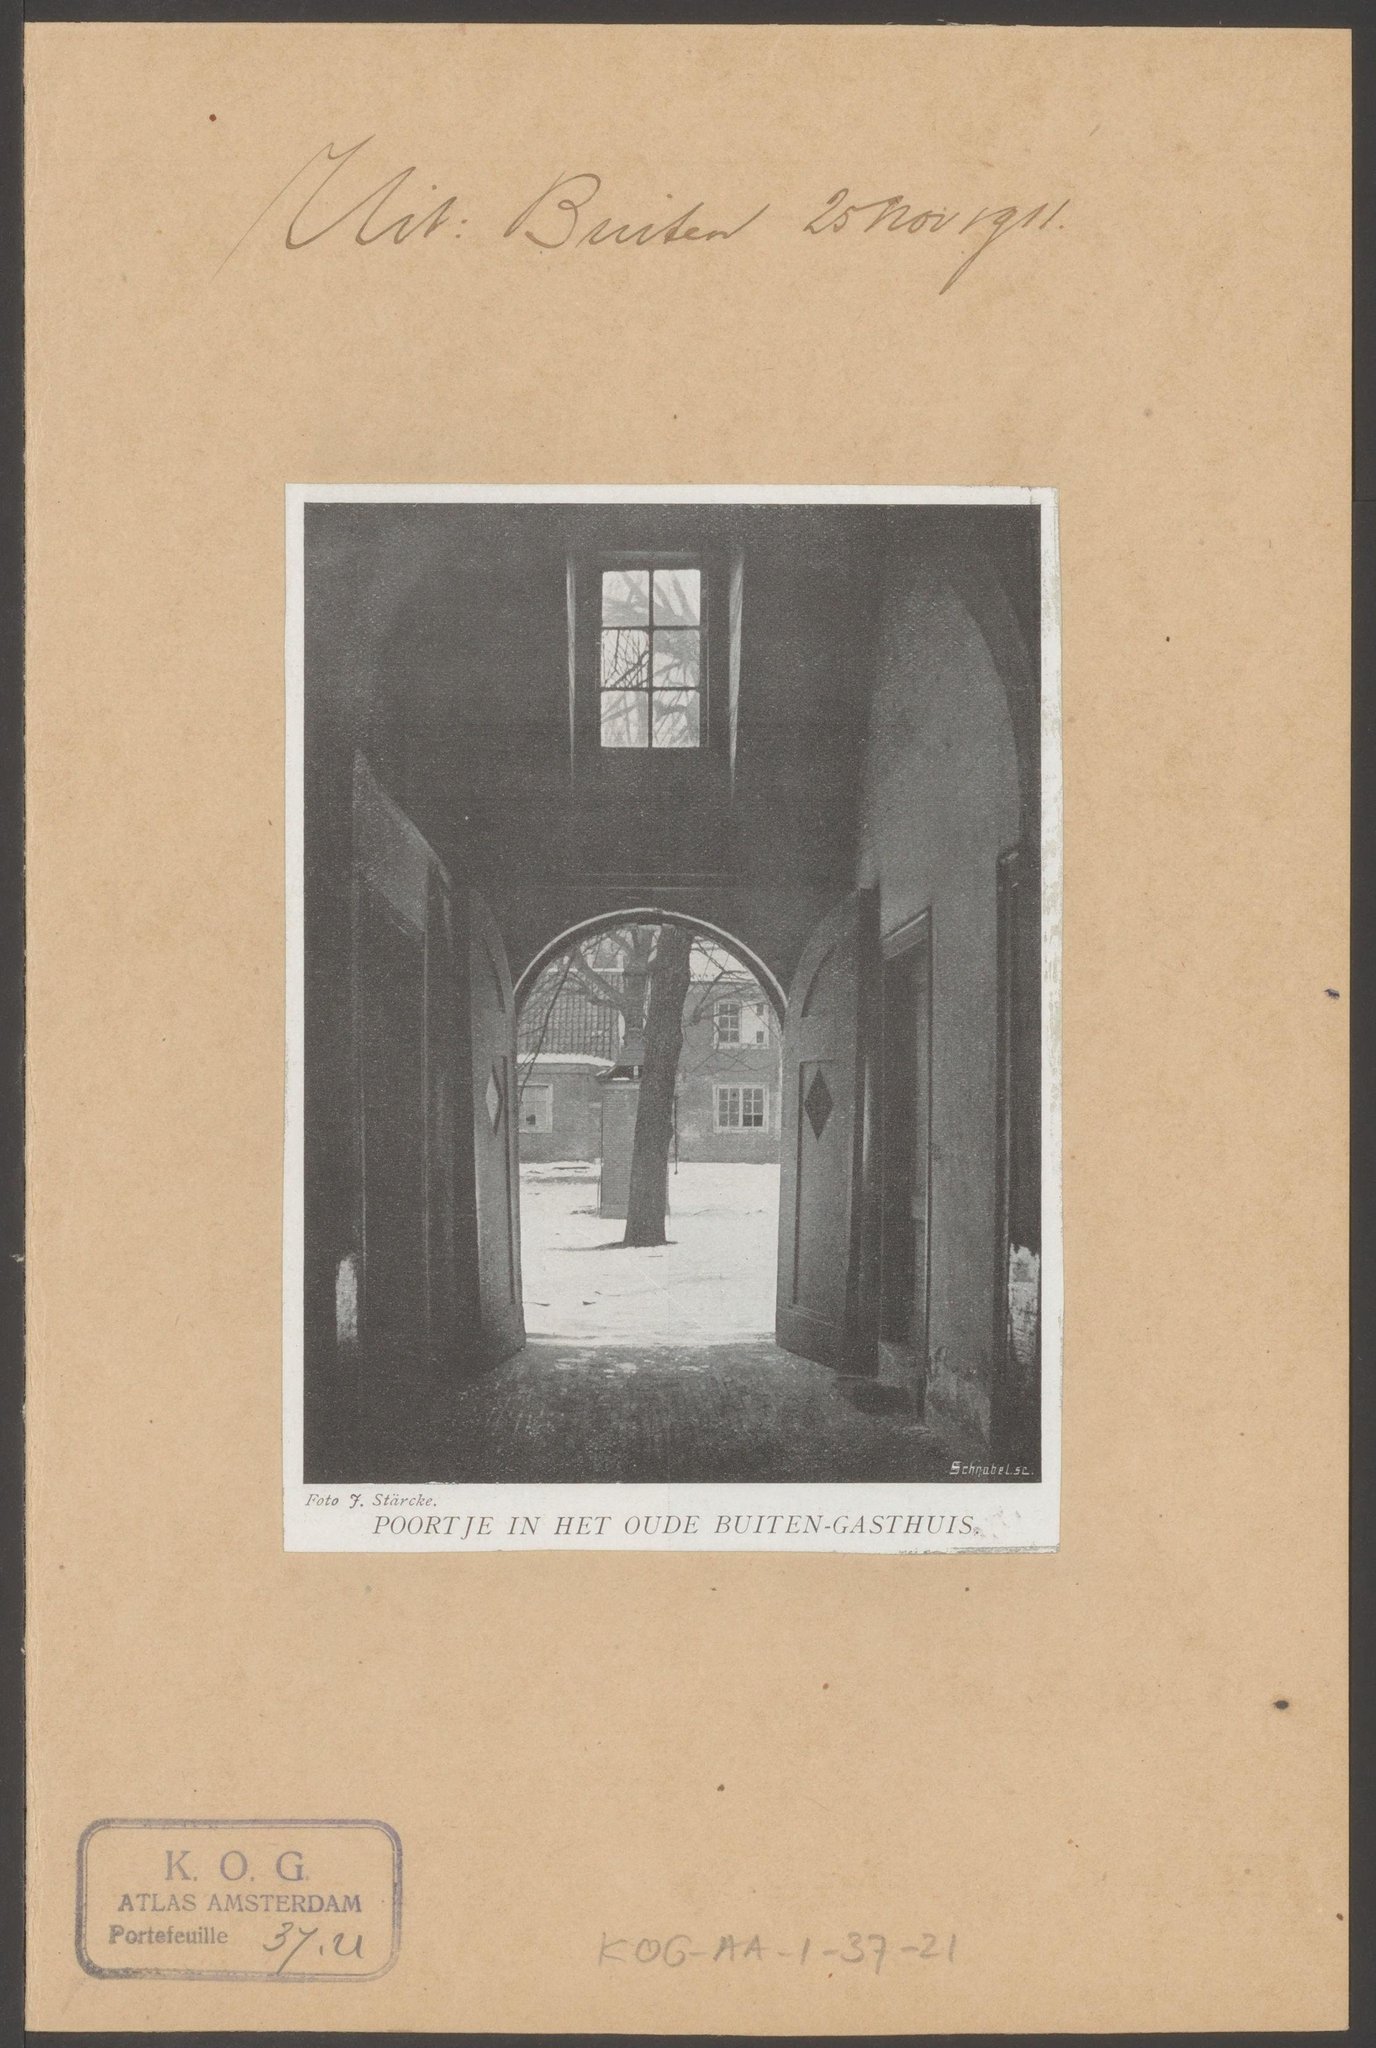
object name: photomechanical print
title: Poortje in het Oude Buiten-Gasthuis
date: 1911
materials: paper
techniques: letterpress printing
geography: amsterdam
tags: gate, entrance, hospital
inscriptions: collector's mark: Lugt 1641b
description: Onderwerpsrubriek binnen de Atlas Amsterdam: Armwezen en liefdadige instellingen: I. Stadsinrichtingen: Buitengasthuis (Pesthuis).